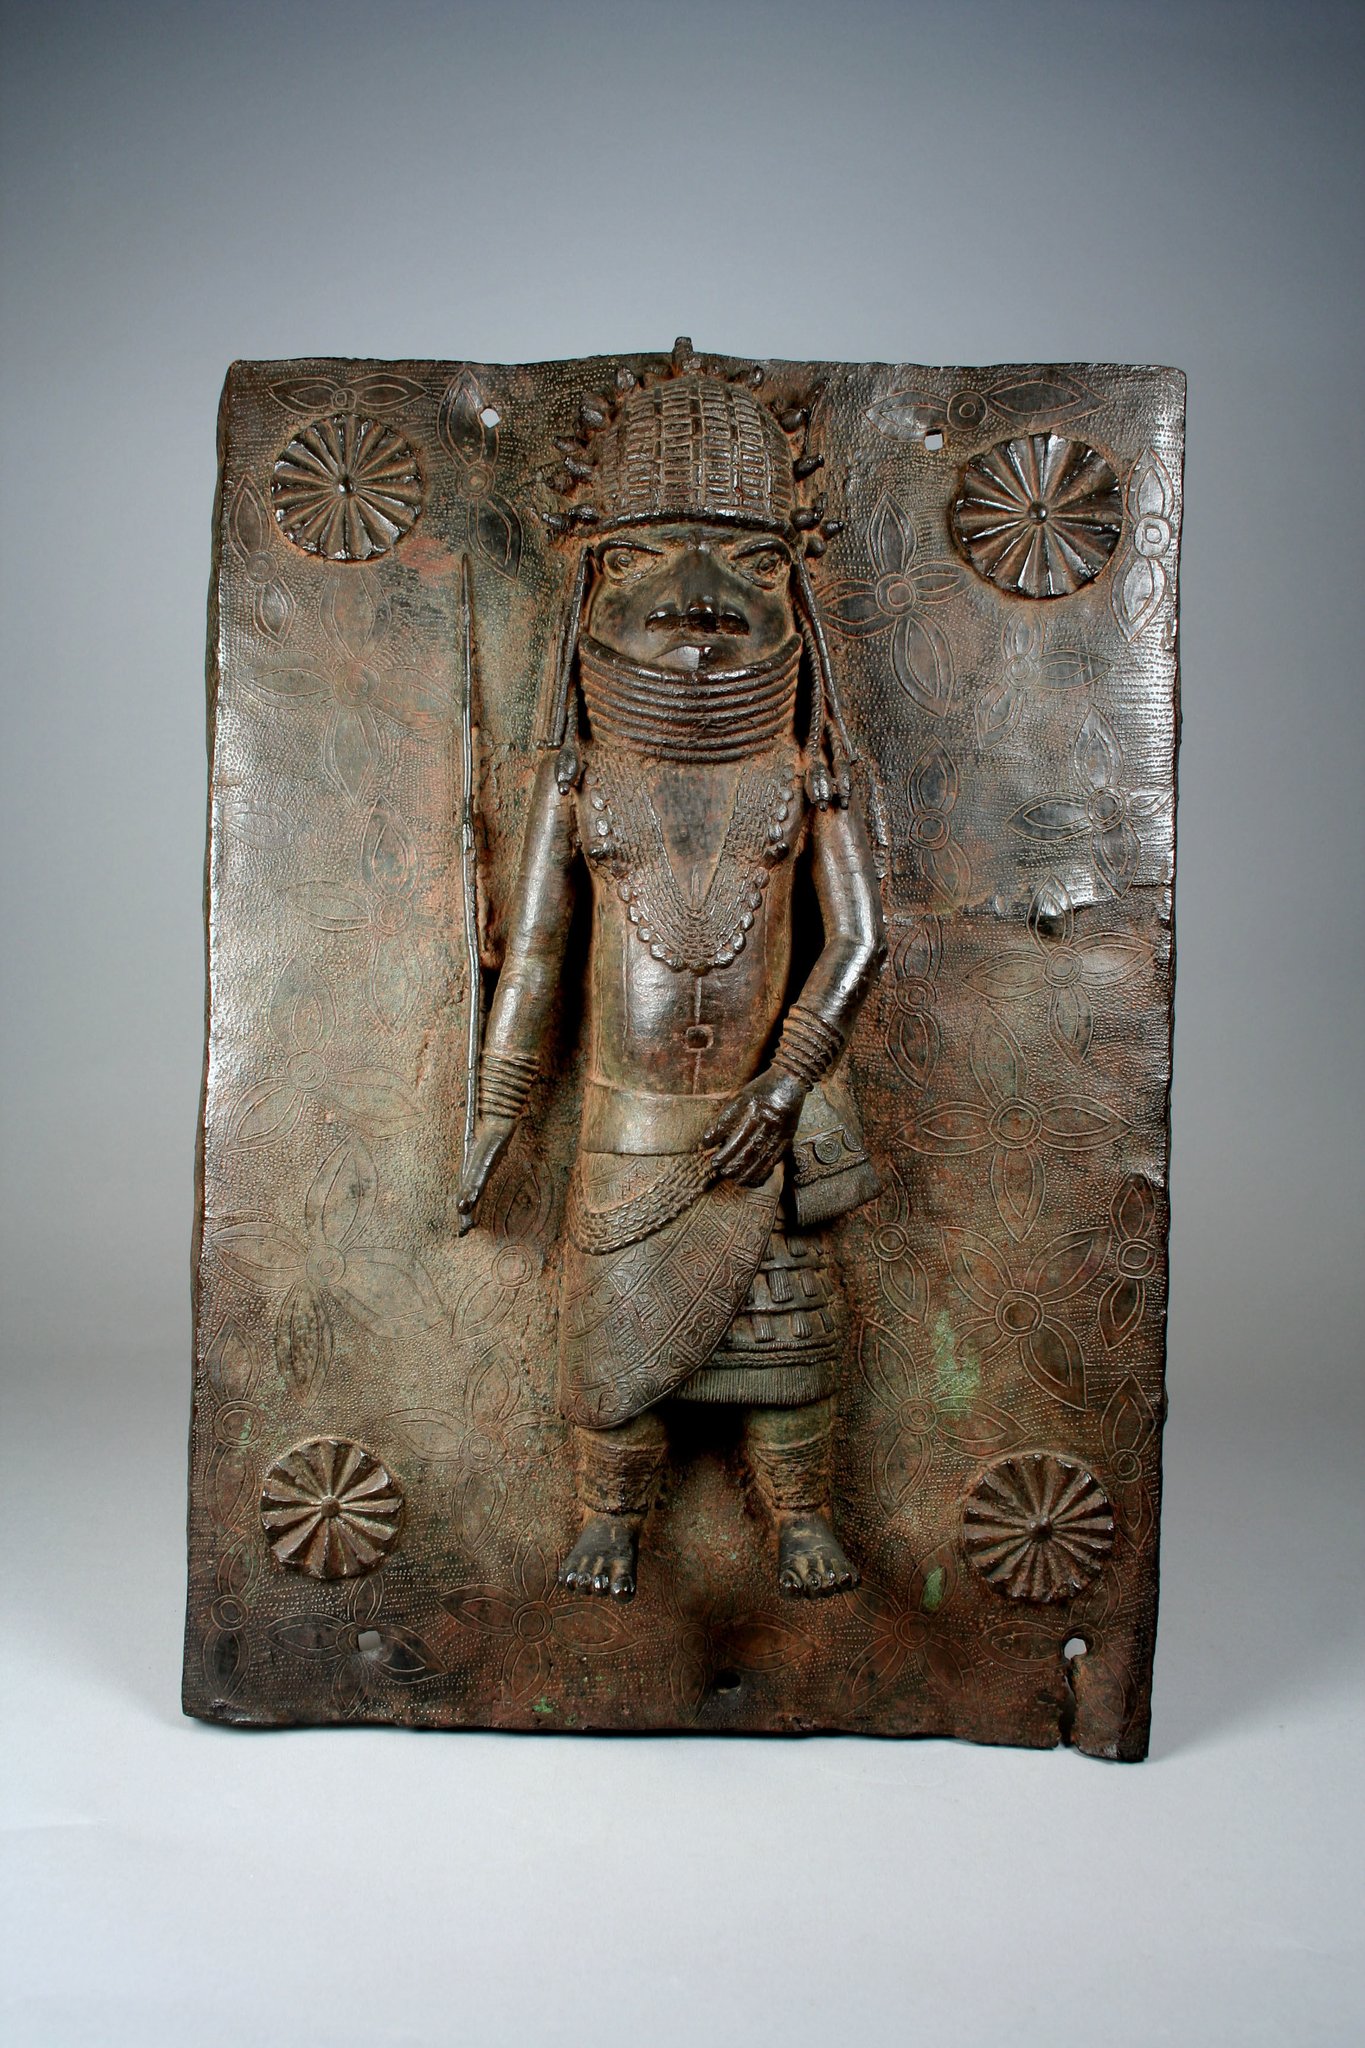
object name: plaque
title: Plaque with Ọ́bà (King) or Chief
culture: edo period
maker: ìgùn ẹ́rọ̀nwwọ̀n (brass-casting guild) artists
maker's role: artist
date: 1540-1570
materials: brass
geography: nigeria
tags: men